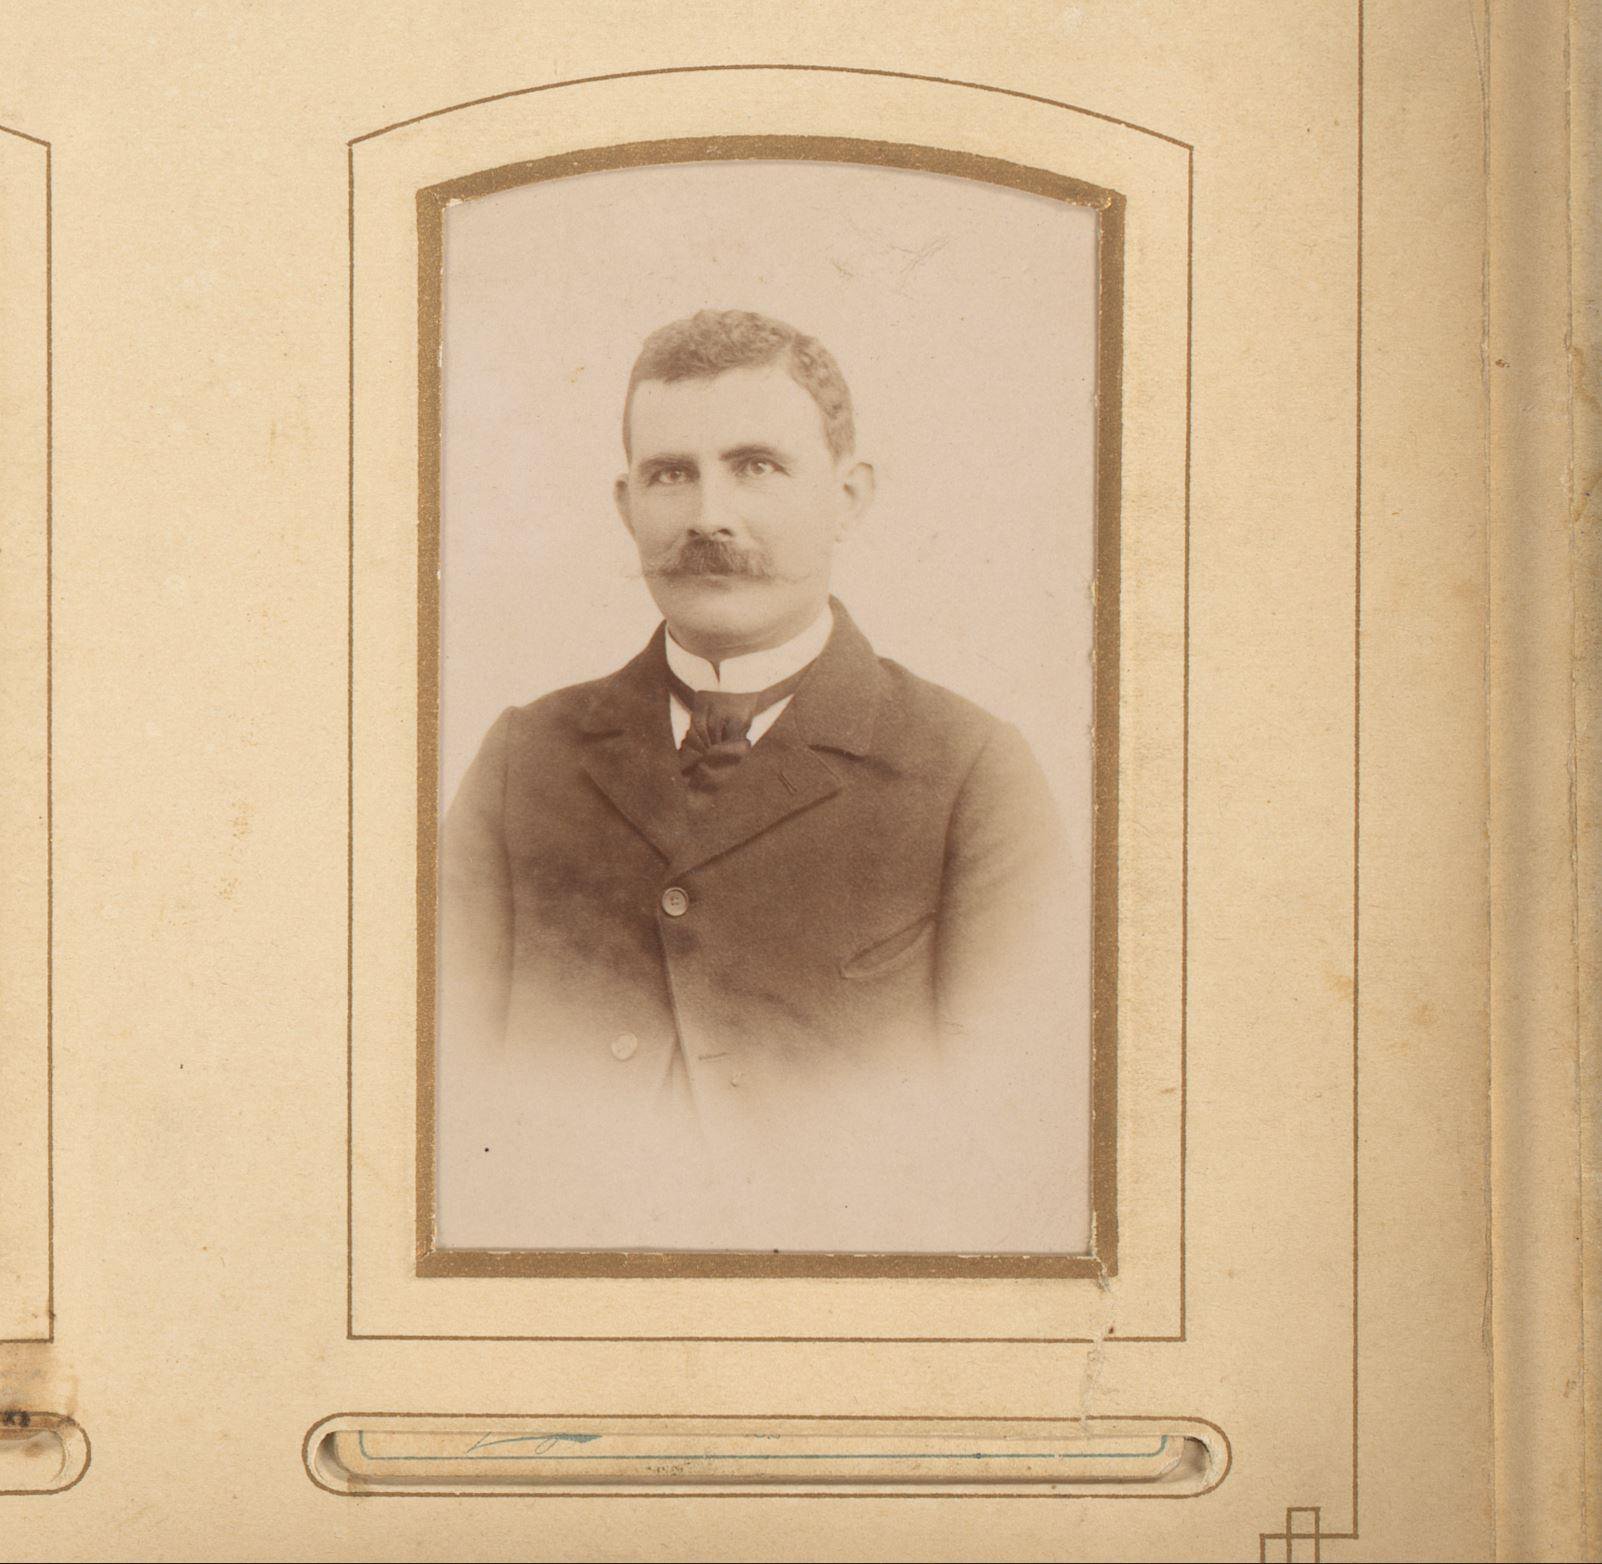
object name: photograph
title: Portret van een man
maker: a. fagel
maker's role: fotograaf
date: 1874-1900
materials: cardboard, photographic support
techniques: albumen print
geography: paris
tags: historical persons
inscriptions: inscription: ‘Maison fondée en 1874/ A. Fagel/ Photographie Artistique/ Rue de Rivoli 76/ Paris’